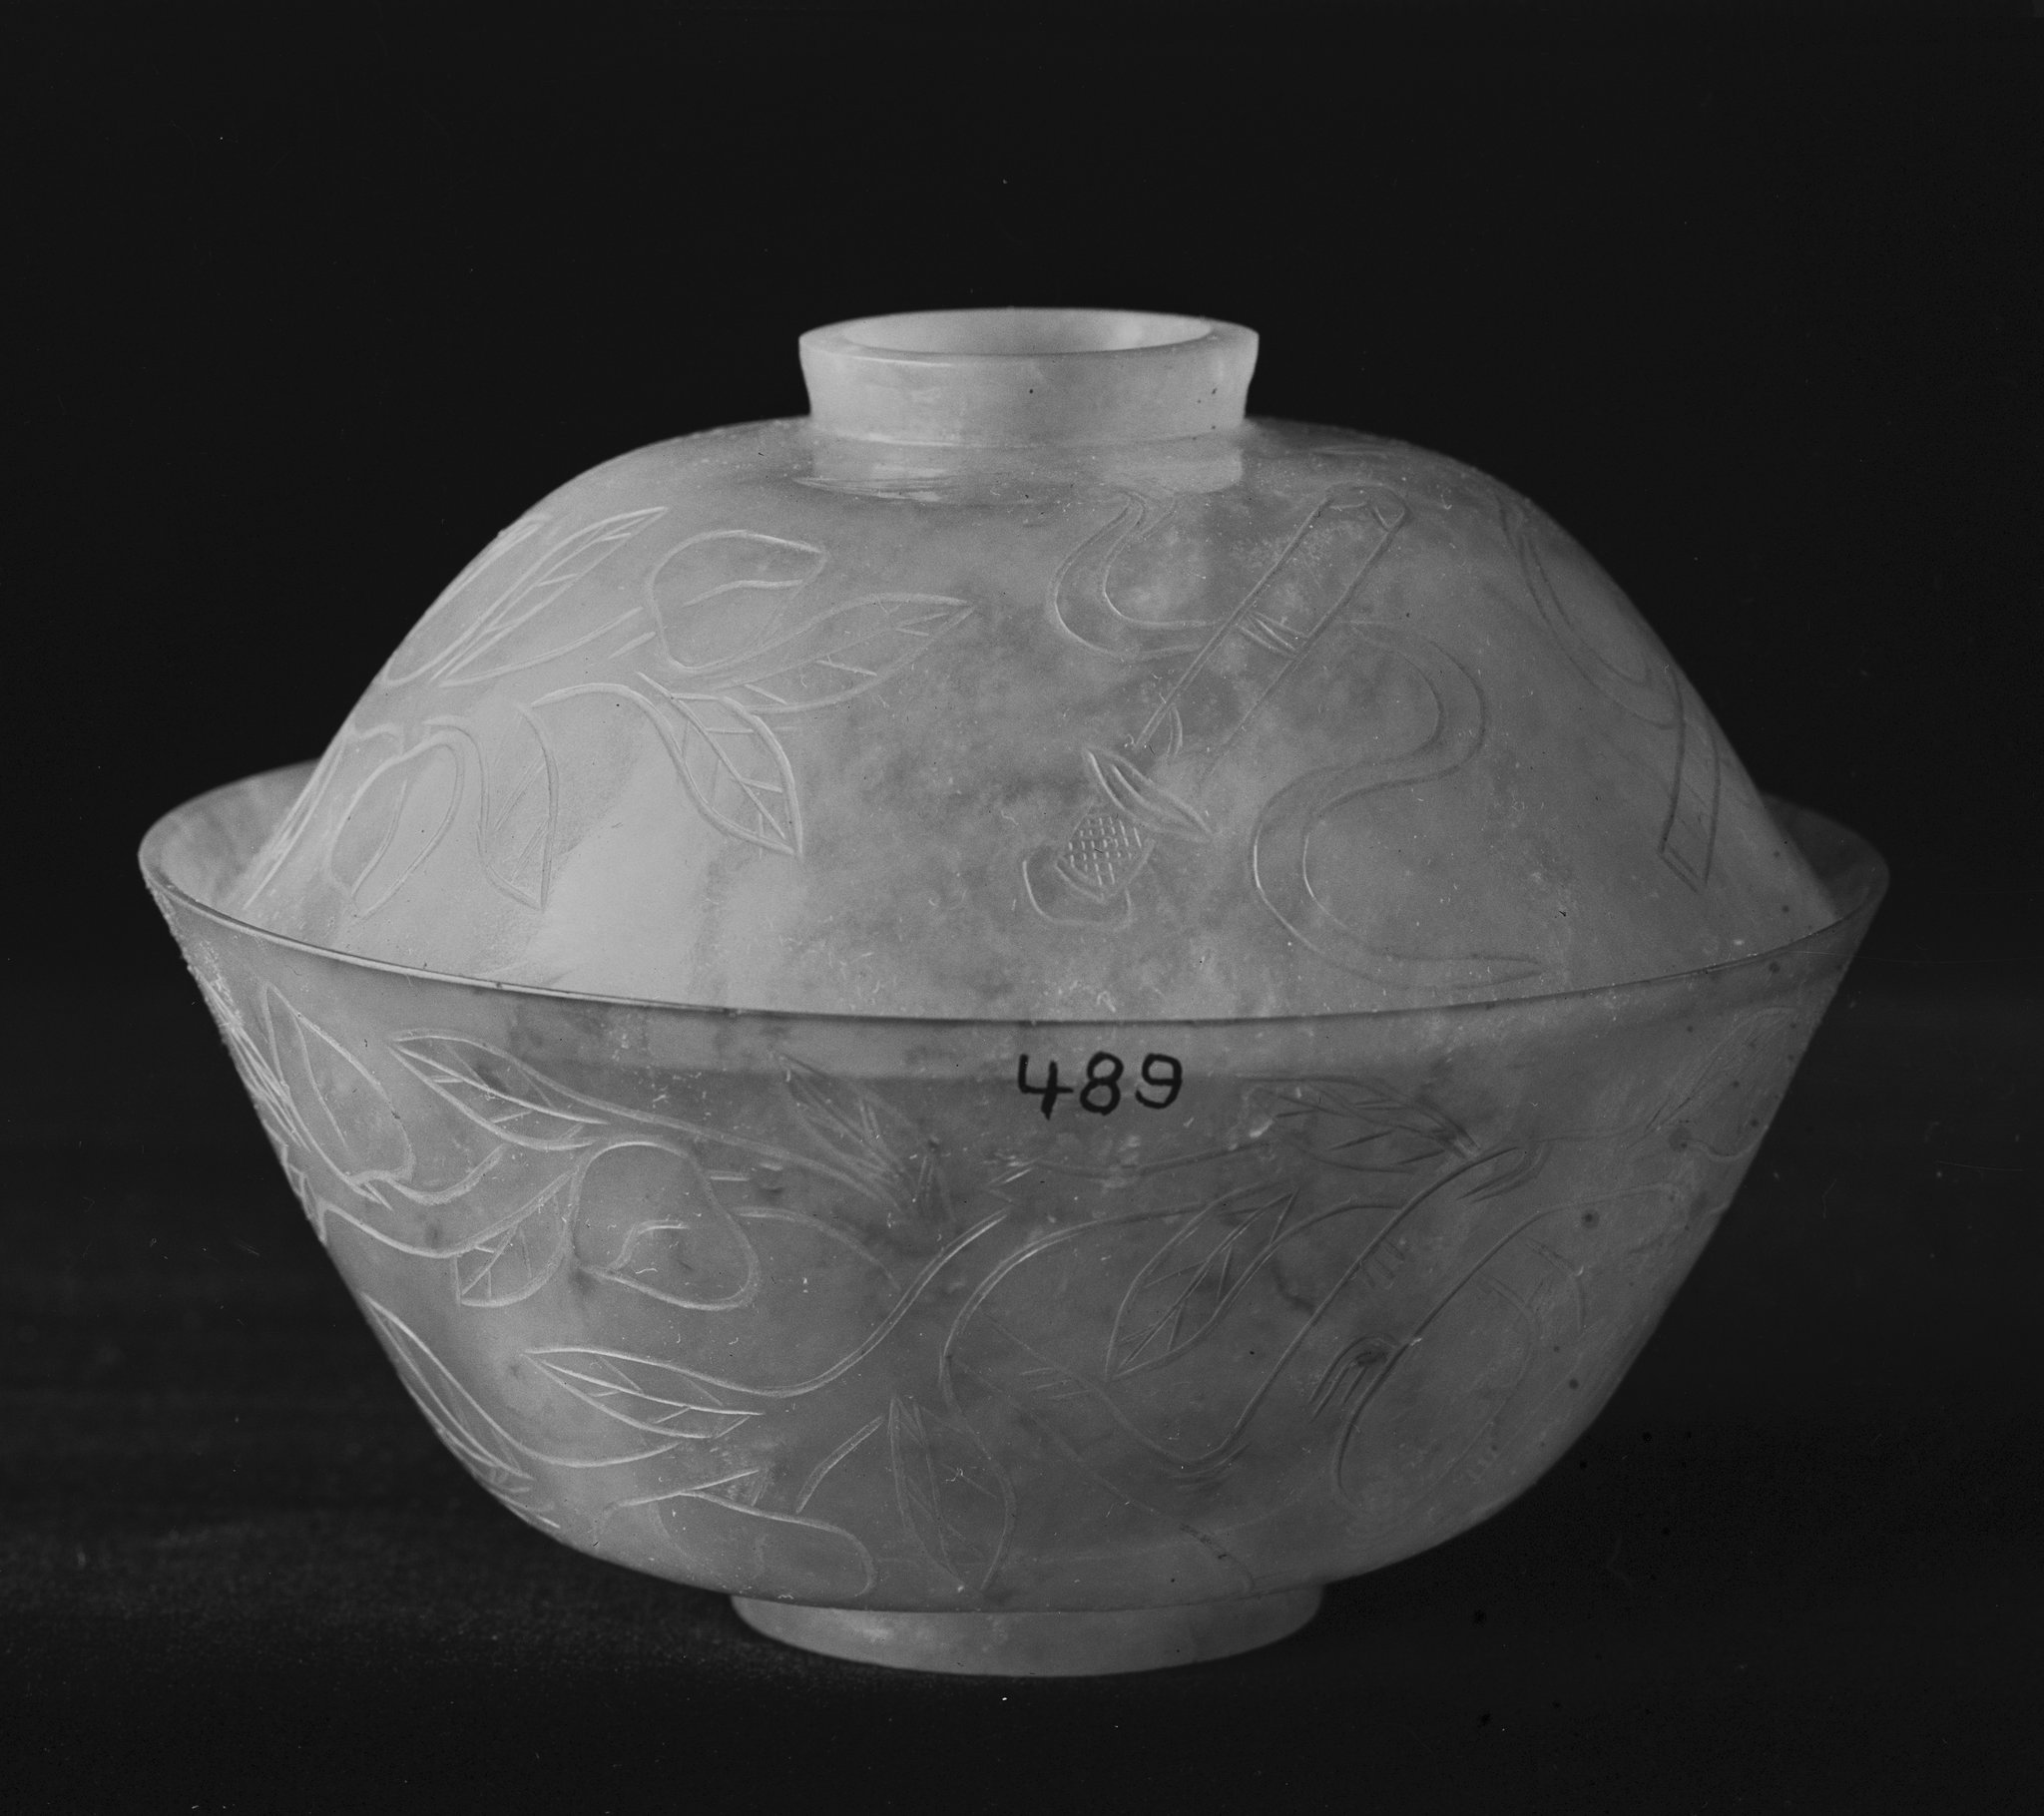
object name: cup with cover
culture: chinese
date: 1736-1795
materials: jade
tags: leaves